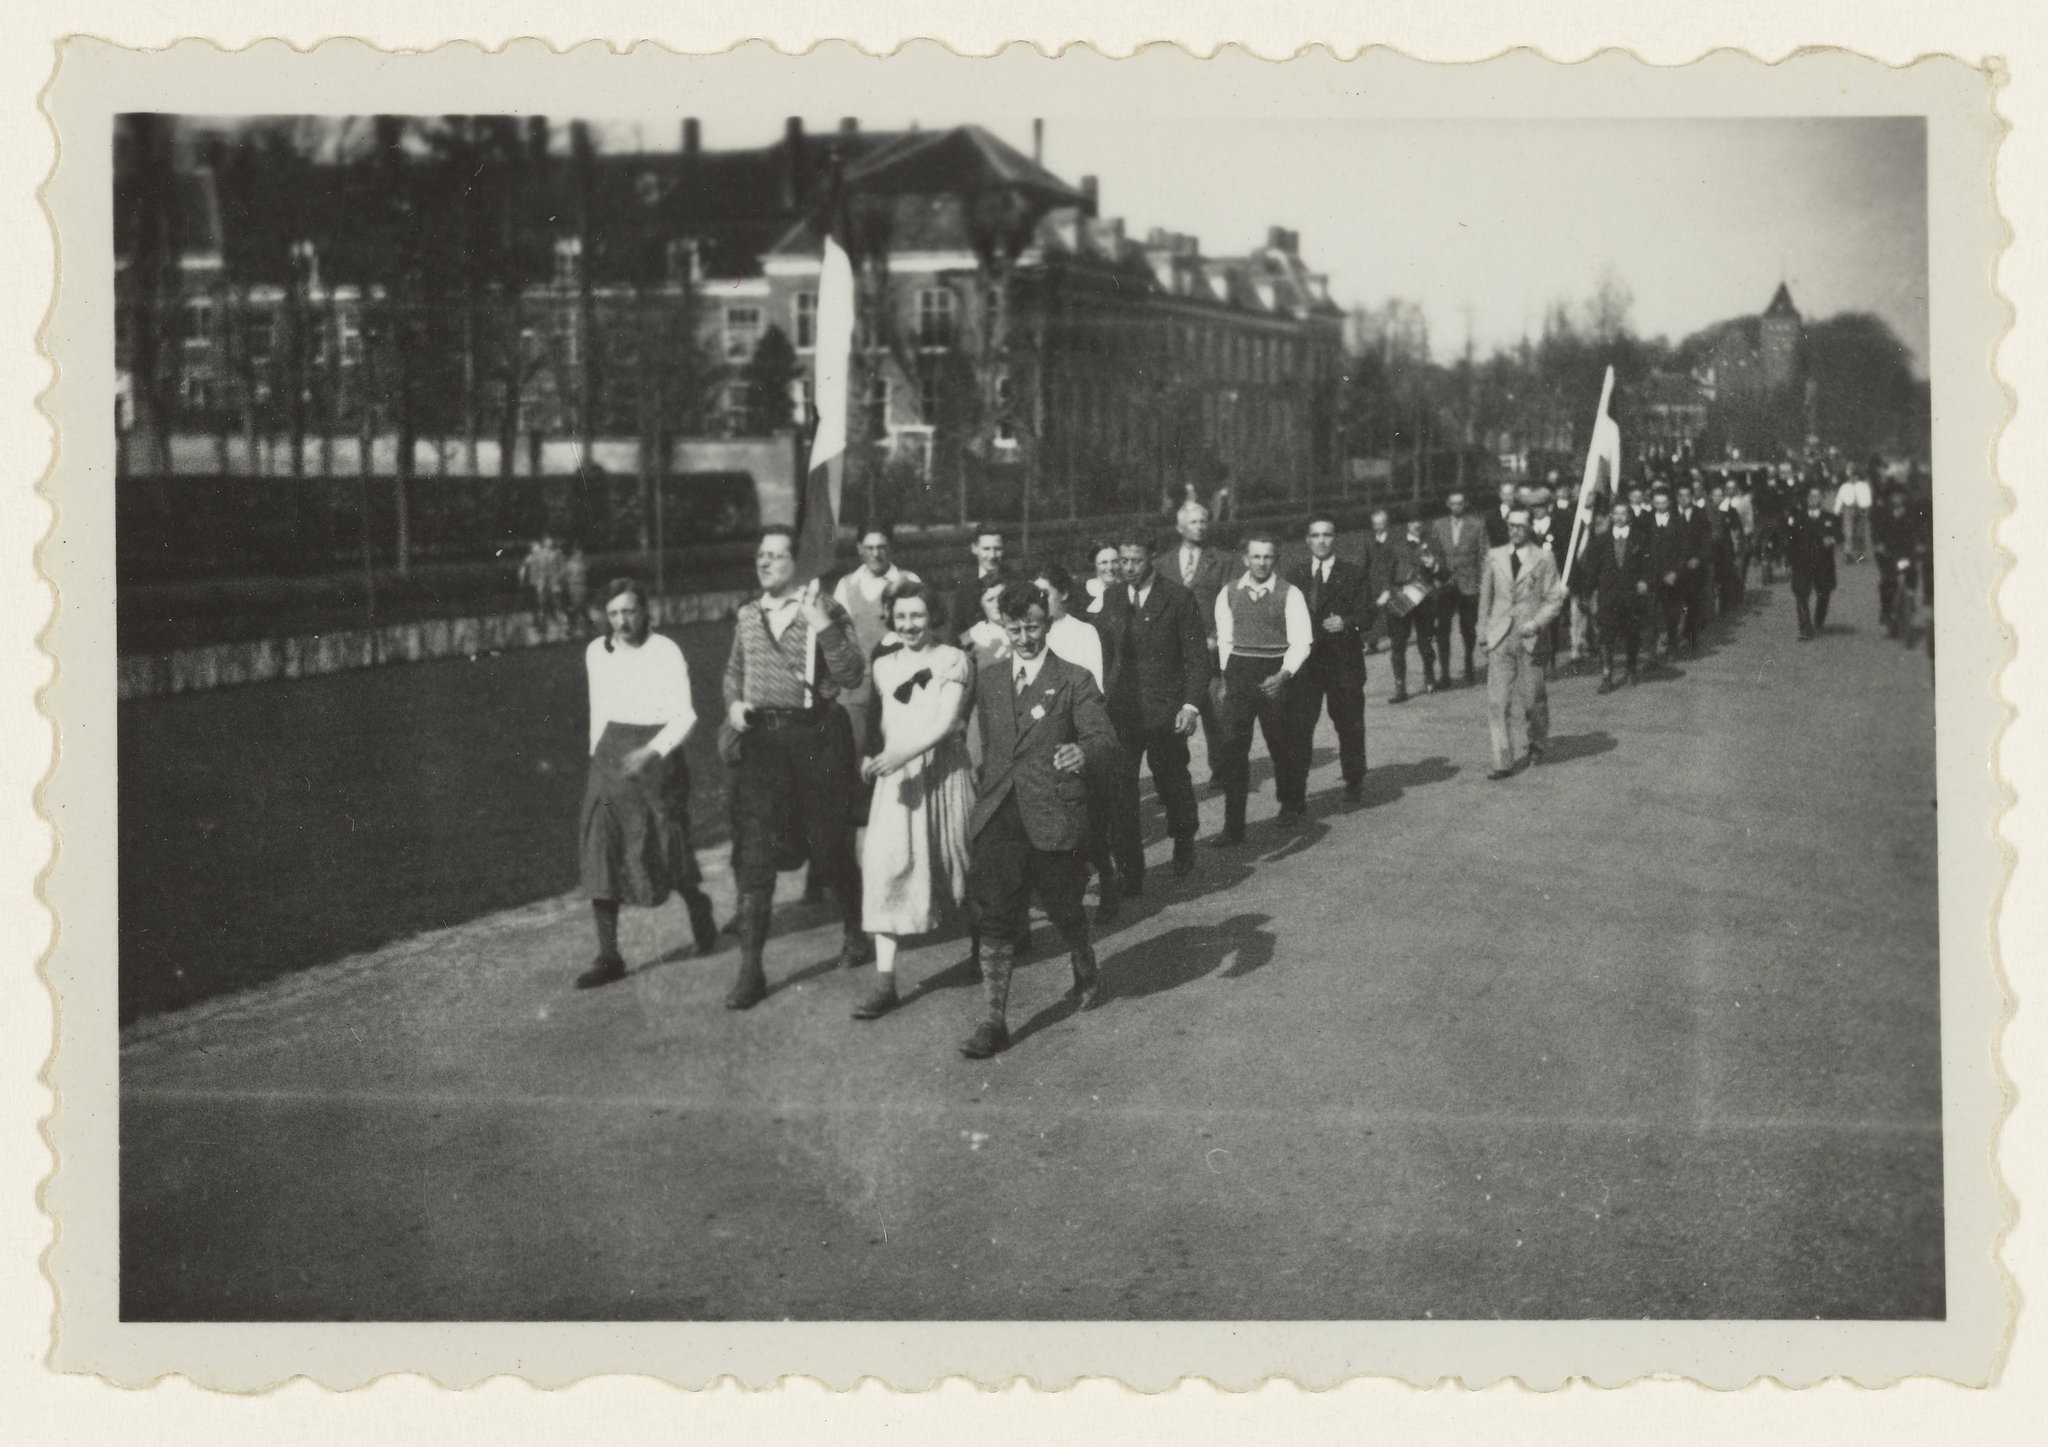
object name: photograph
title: Optocht NSB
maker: Anonymous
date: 1936-1937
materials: photographic support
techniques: photography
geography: utrecht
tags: military parade, pageant, amsterdam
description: Optocht van de NSB. Voorop een man met de Nederlandse vlag in een geruite pullover. Niemand is in uniform, wel hebben sommigen hoge laarzen aan. Vanaf 1936 gold voor de NSB en aan hen verwante organisaties een verbod om in uniform op straat te verschijnen.